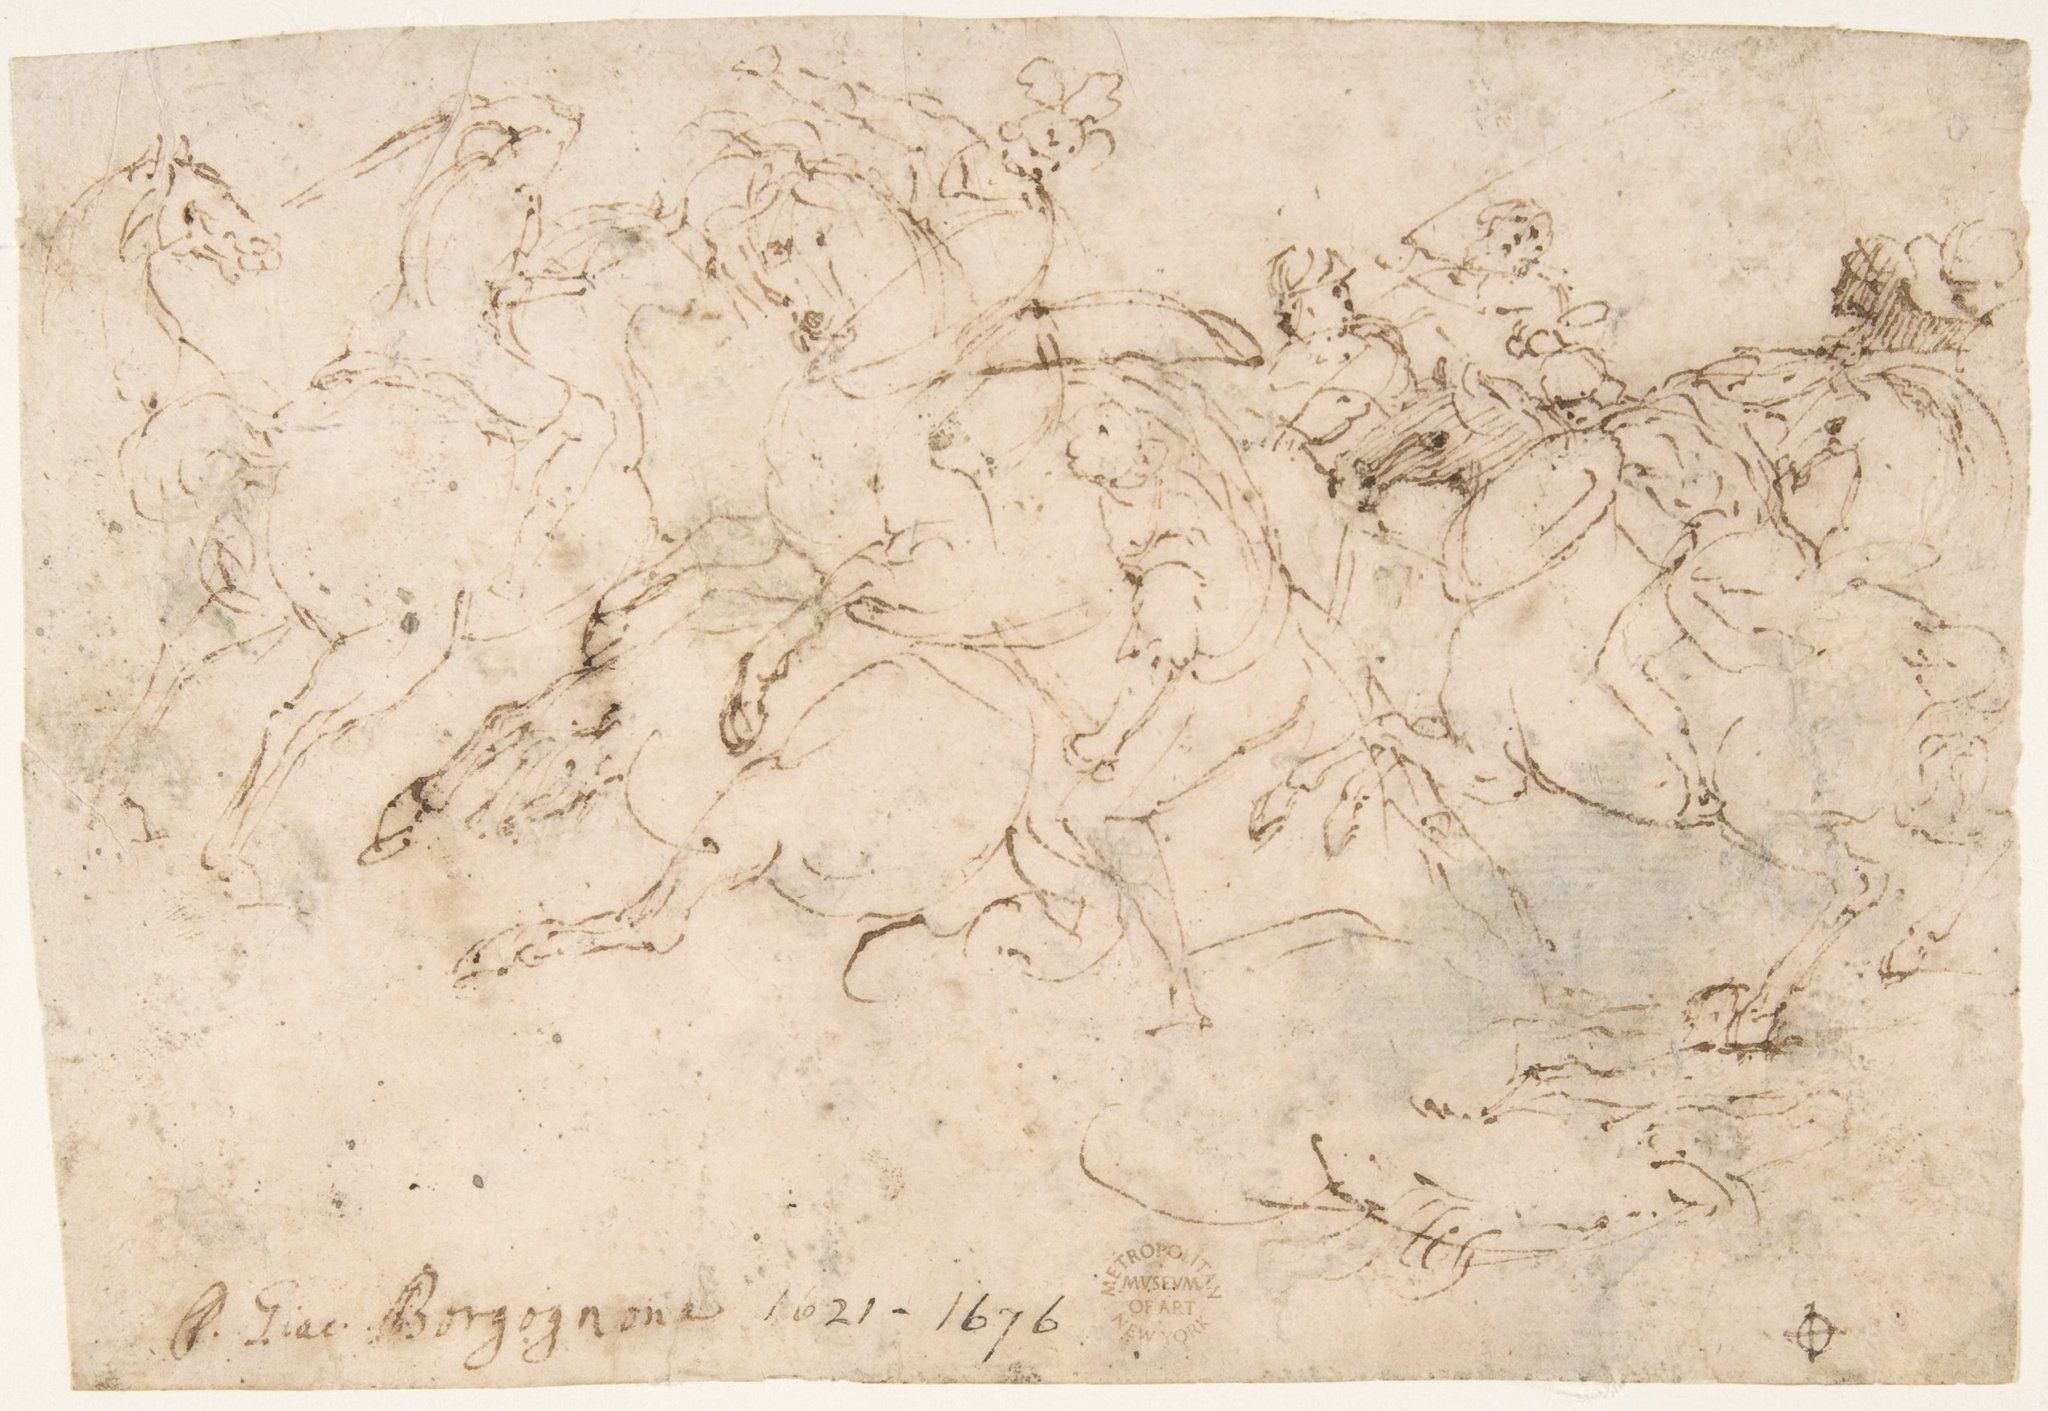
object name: drawing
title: Cavalry Engagement (recto); Concert of Angels (verso)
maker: francesco allegrini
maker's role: artist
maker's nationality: italian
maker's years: 1615-1679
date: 1624-1663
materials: ink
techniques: pen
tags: men,horses,angels